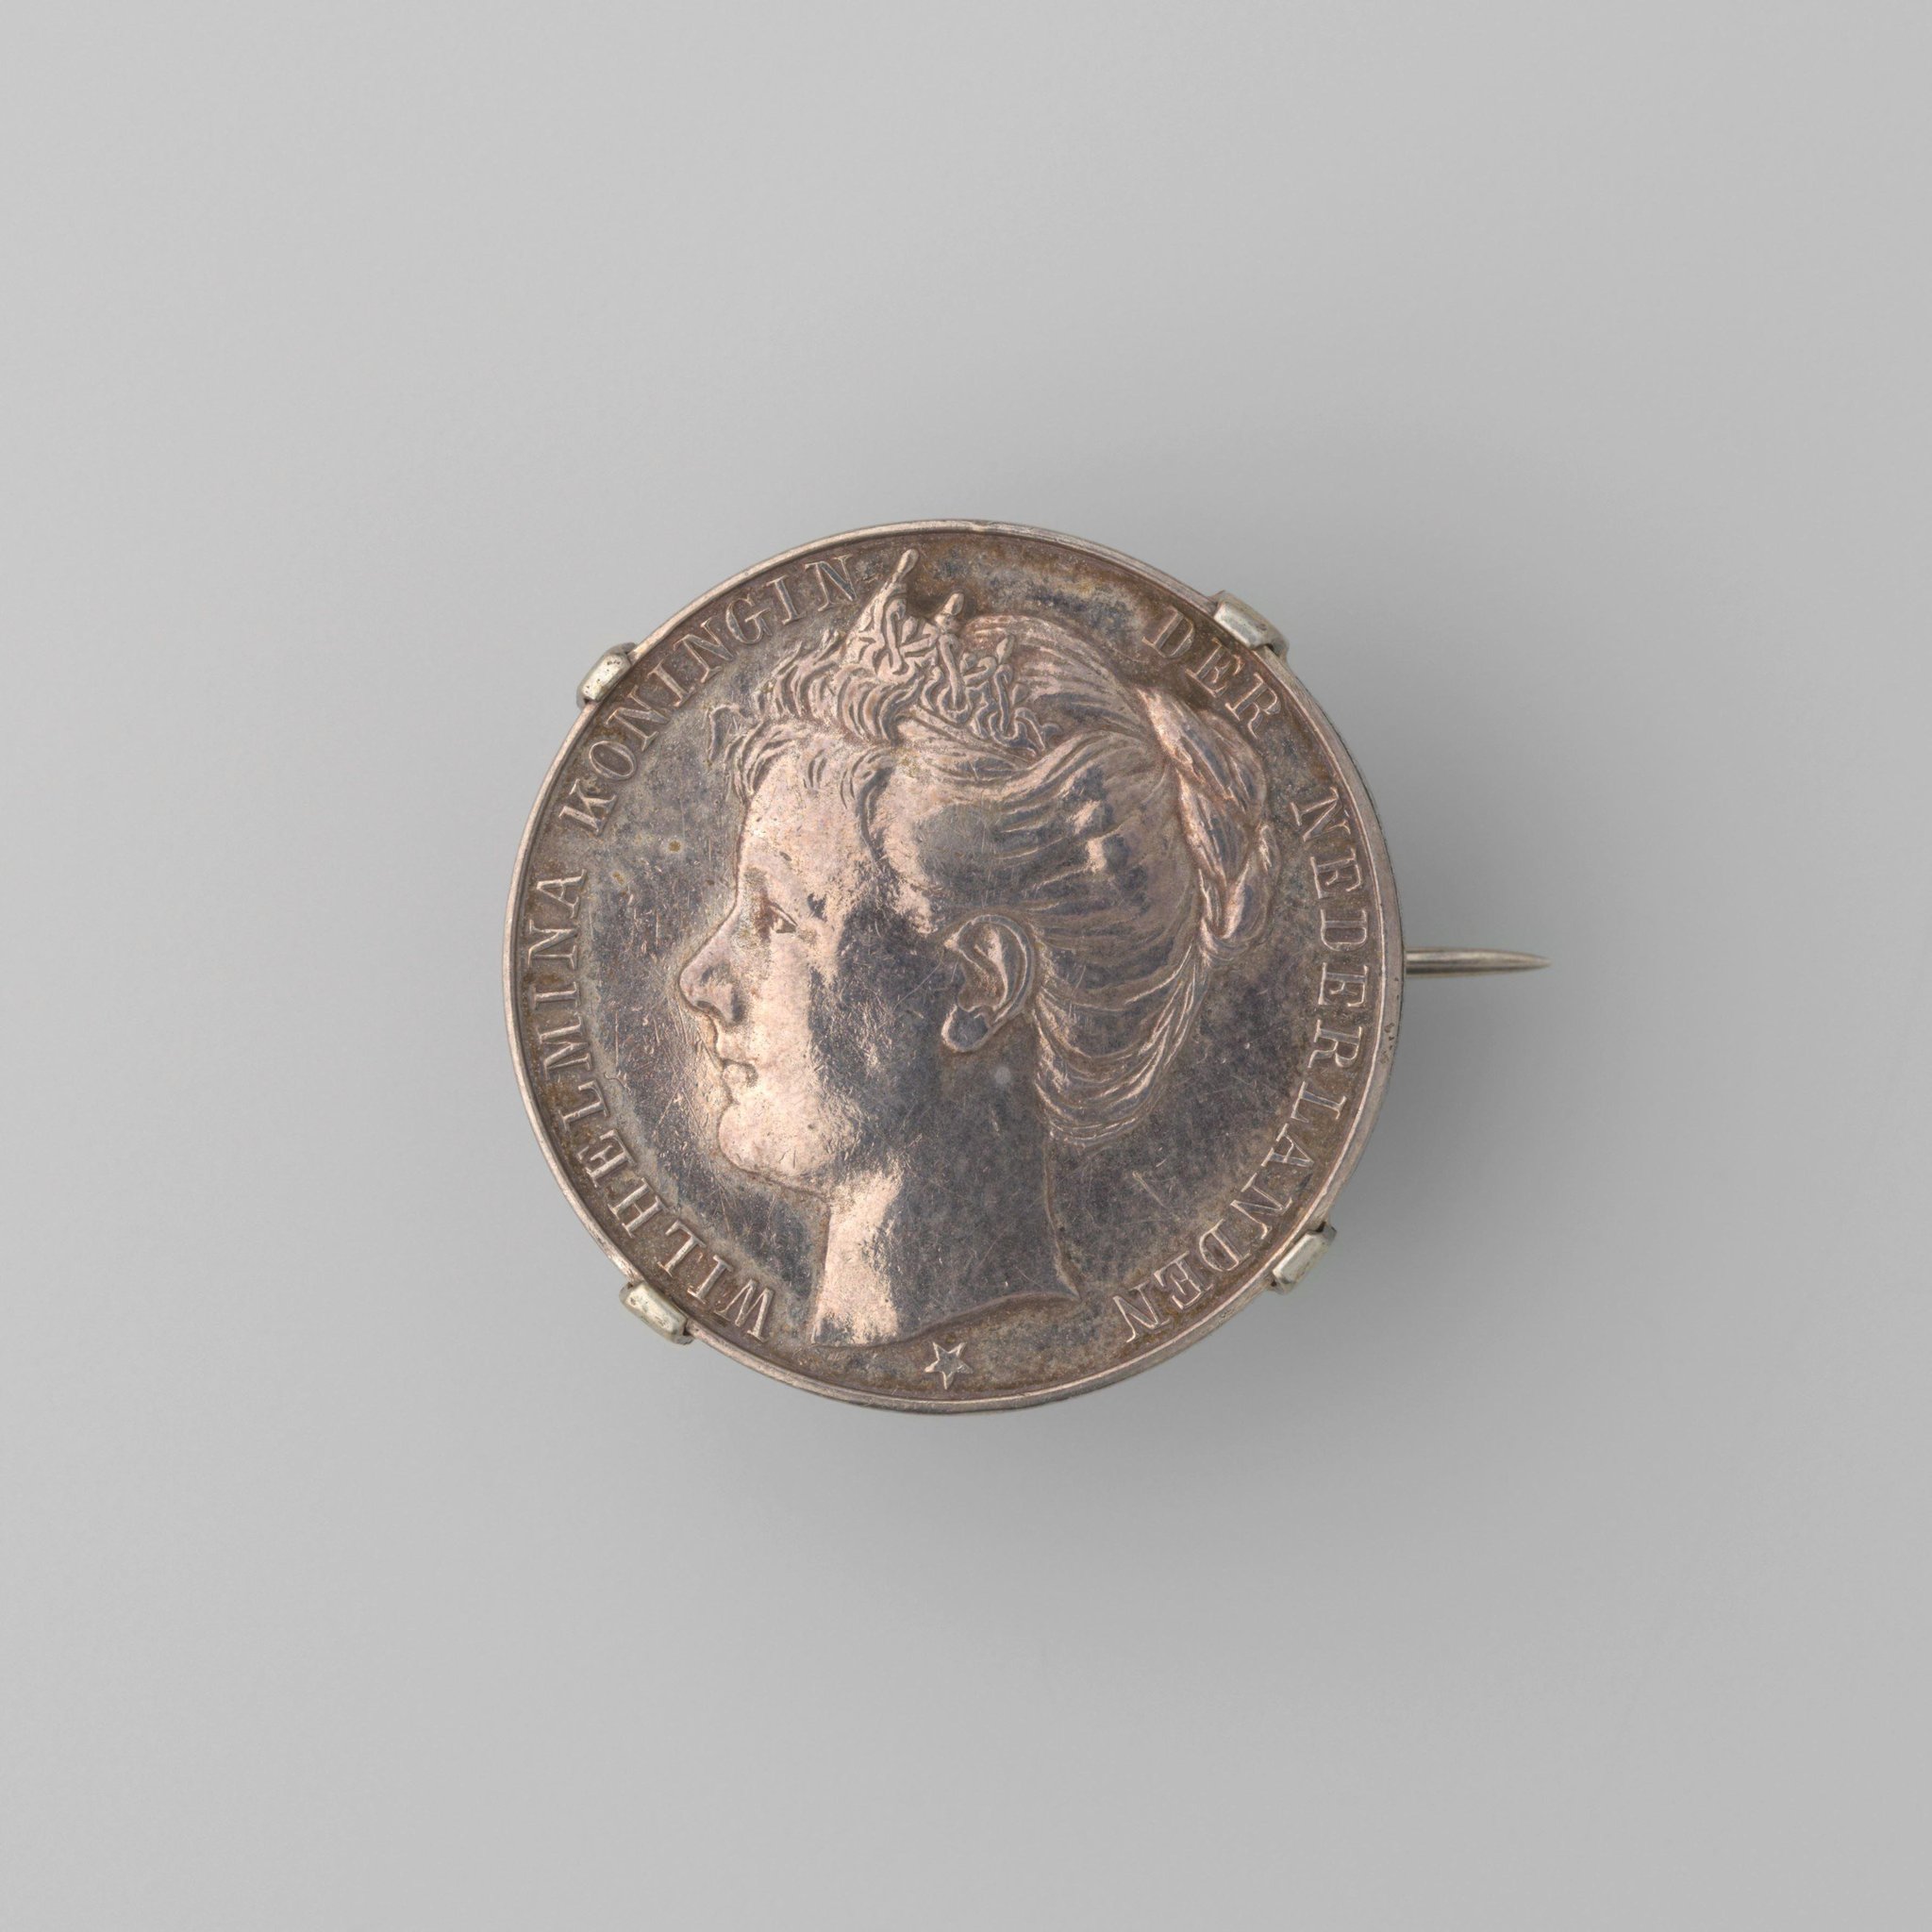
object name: brooch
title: Broche van zilveren munt met beeldenaar van Wilhelmina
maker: Anonymous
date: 1940-1950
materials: silver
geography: netherlands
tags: the hague, print maker, wilhelmina of the netherlands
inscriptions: alloy mark: ‘oud zwaard’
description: Broche van zilveren munt met beeldenaar van Wilhelmina, voorzien van een haaksluiting. Ter gelegenheid van de inhuldiging in 1898. De munt is gevat in een muntrand.